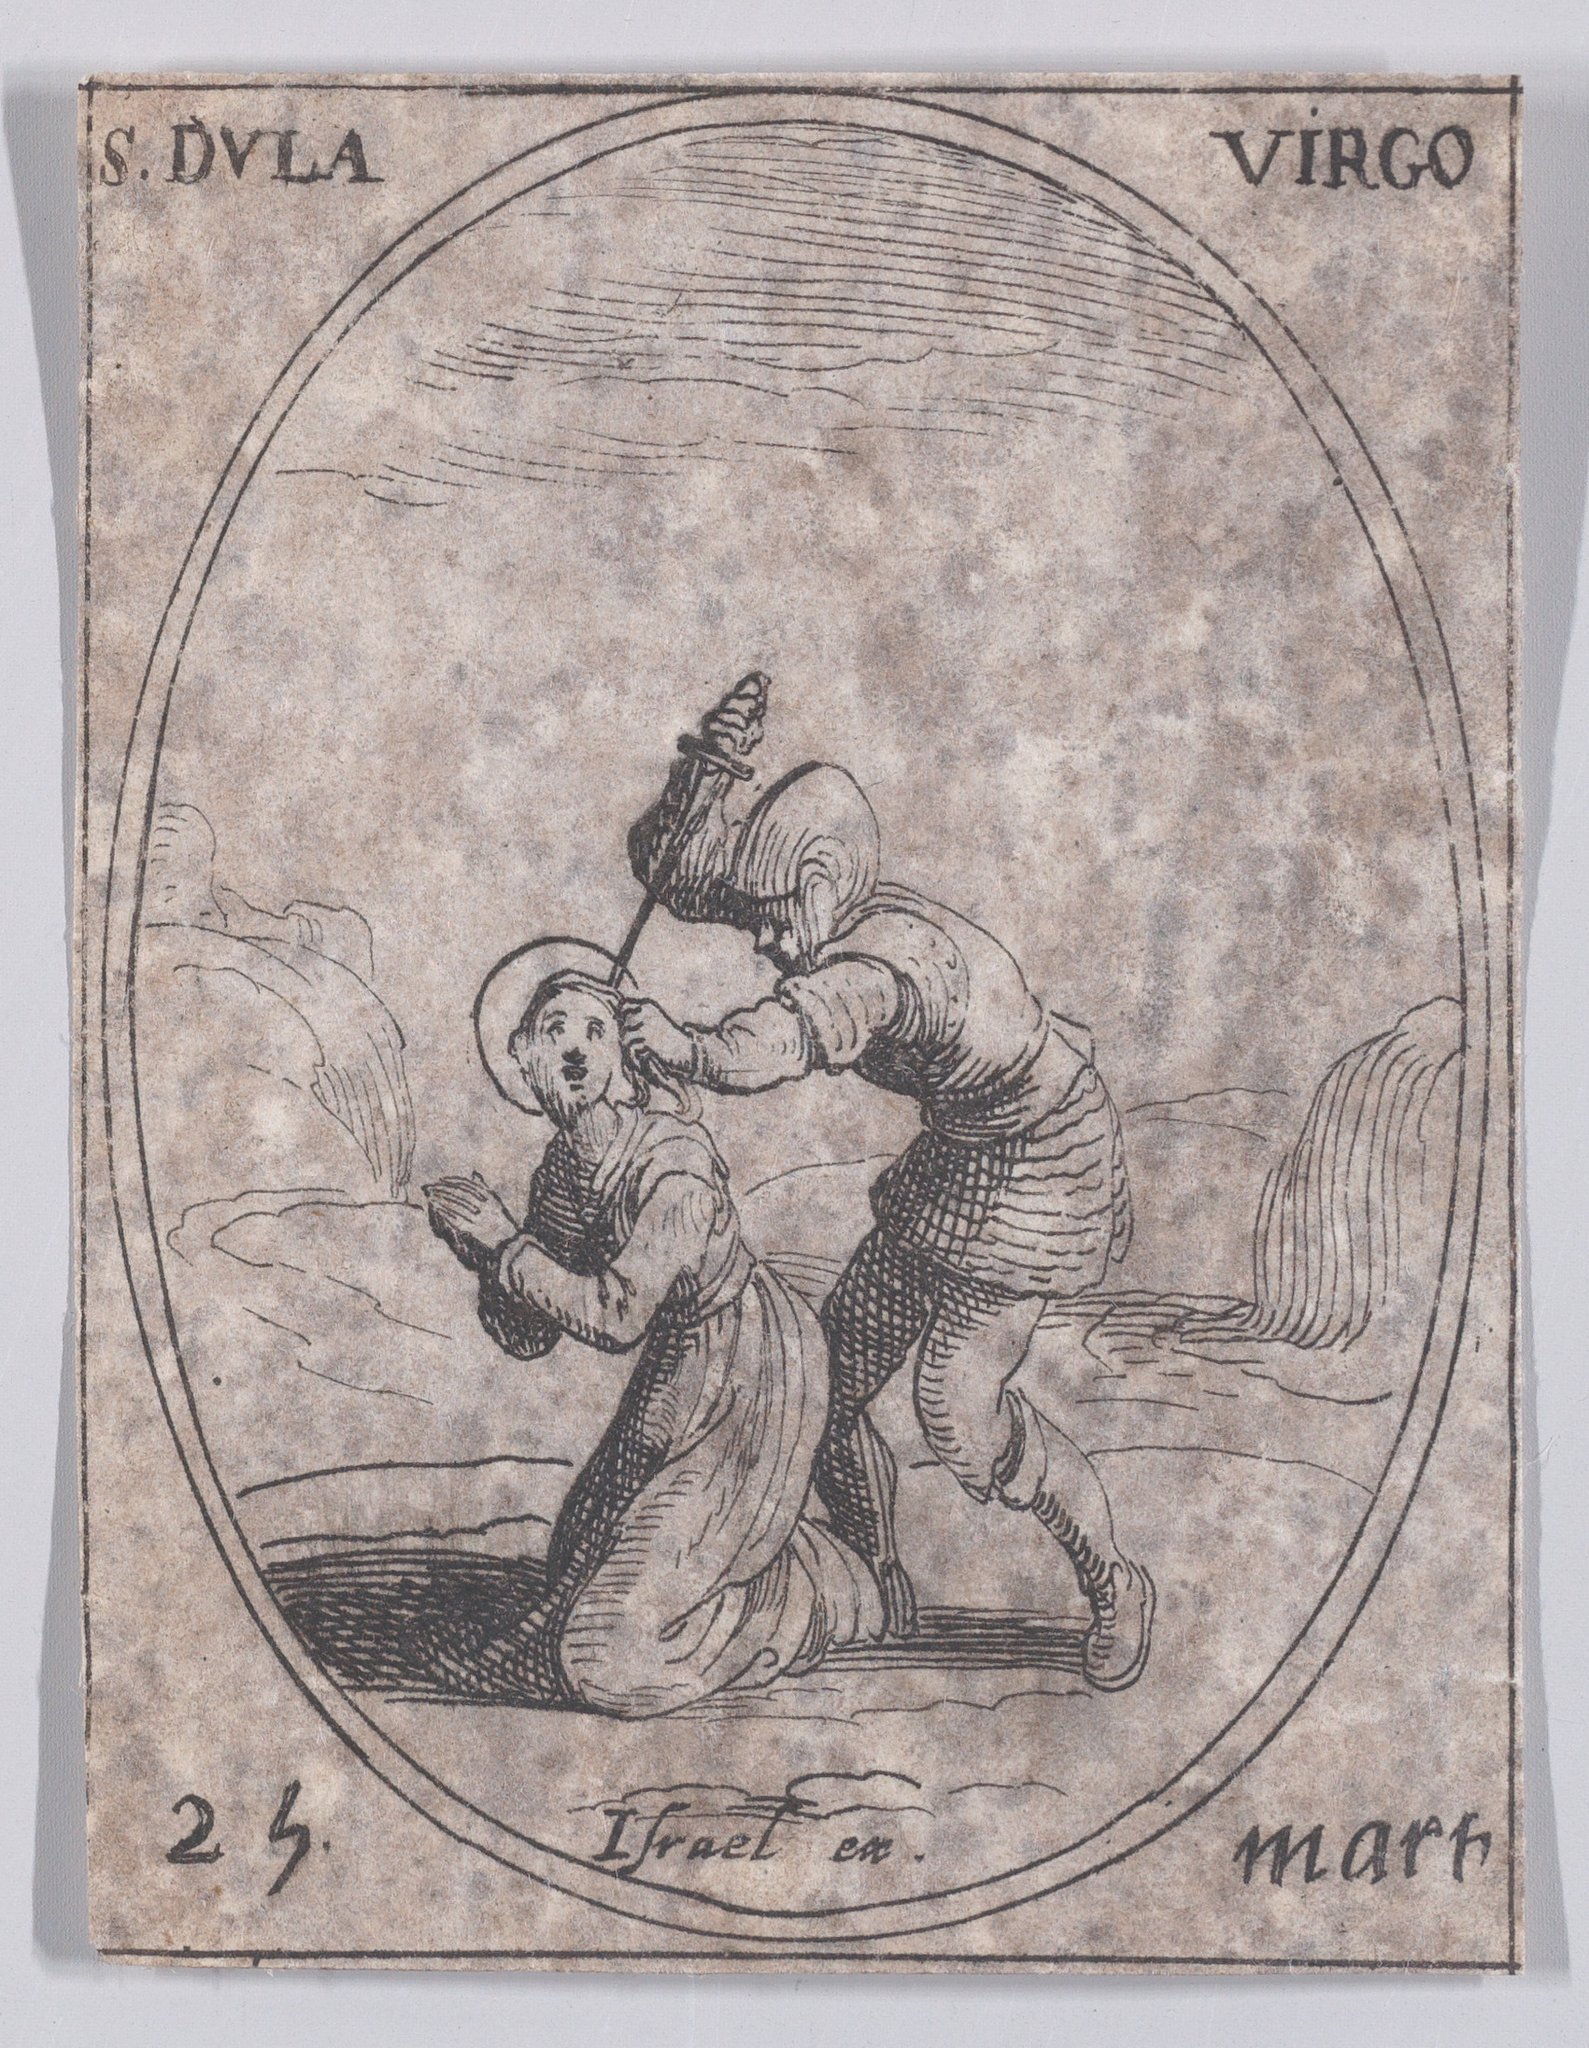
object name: print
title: Ste. Dule, vierge (St. Dula, Virgin), March 25th, from "Les Images De Tous Les Saincts et Saintes de L'Année" (Images of All of the Saints and Religious Events of the Year)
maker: jacques callot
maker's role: artist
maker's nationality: french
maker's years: 1592-1635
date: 1636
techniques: etching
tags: men,women,saints